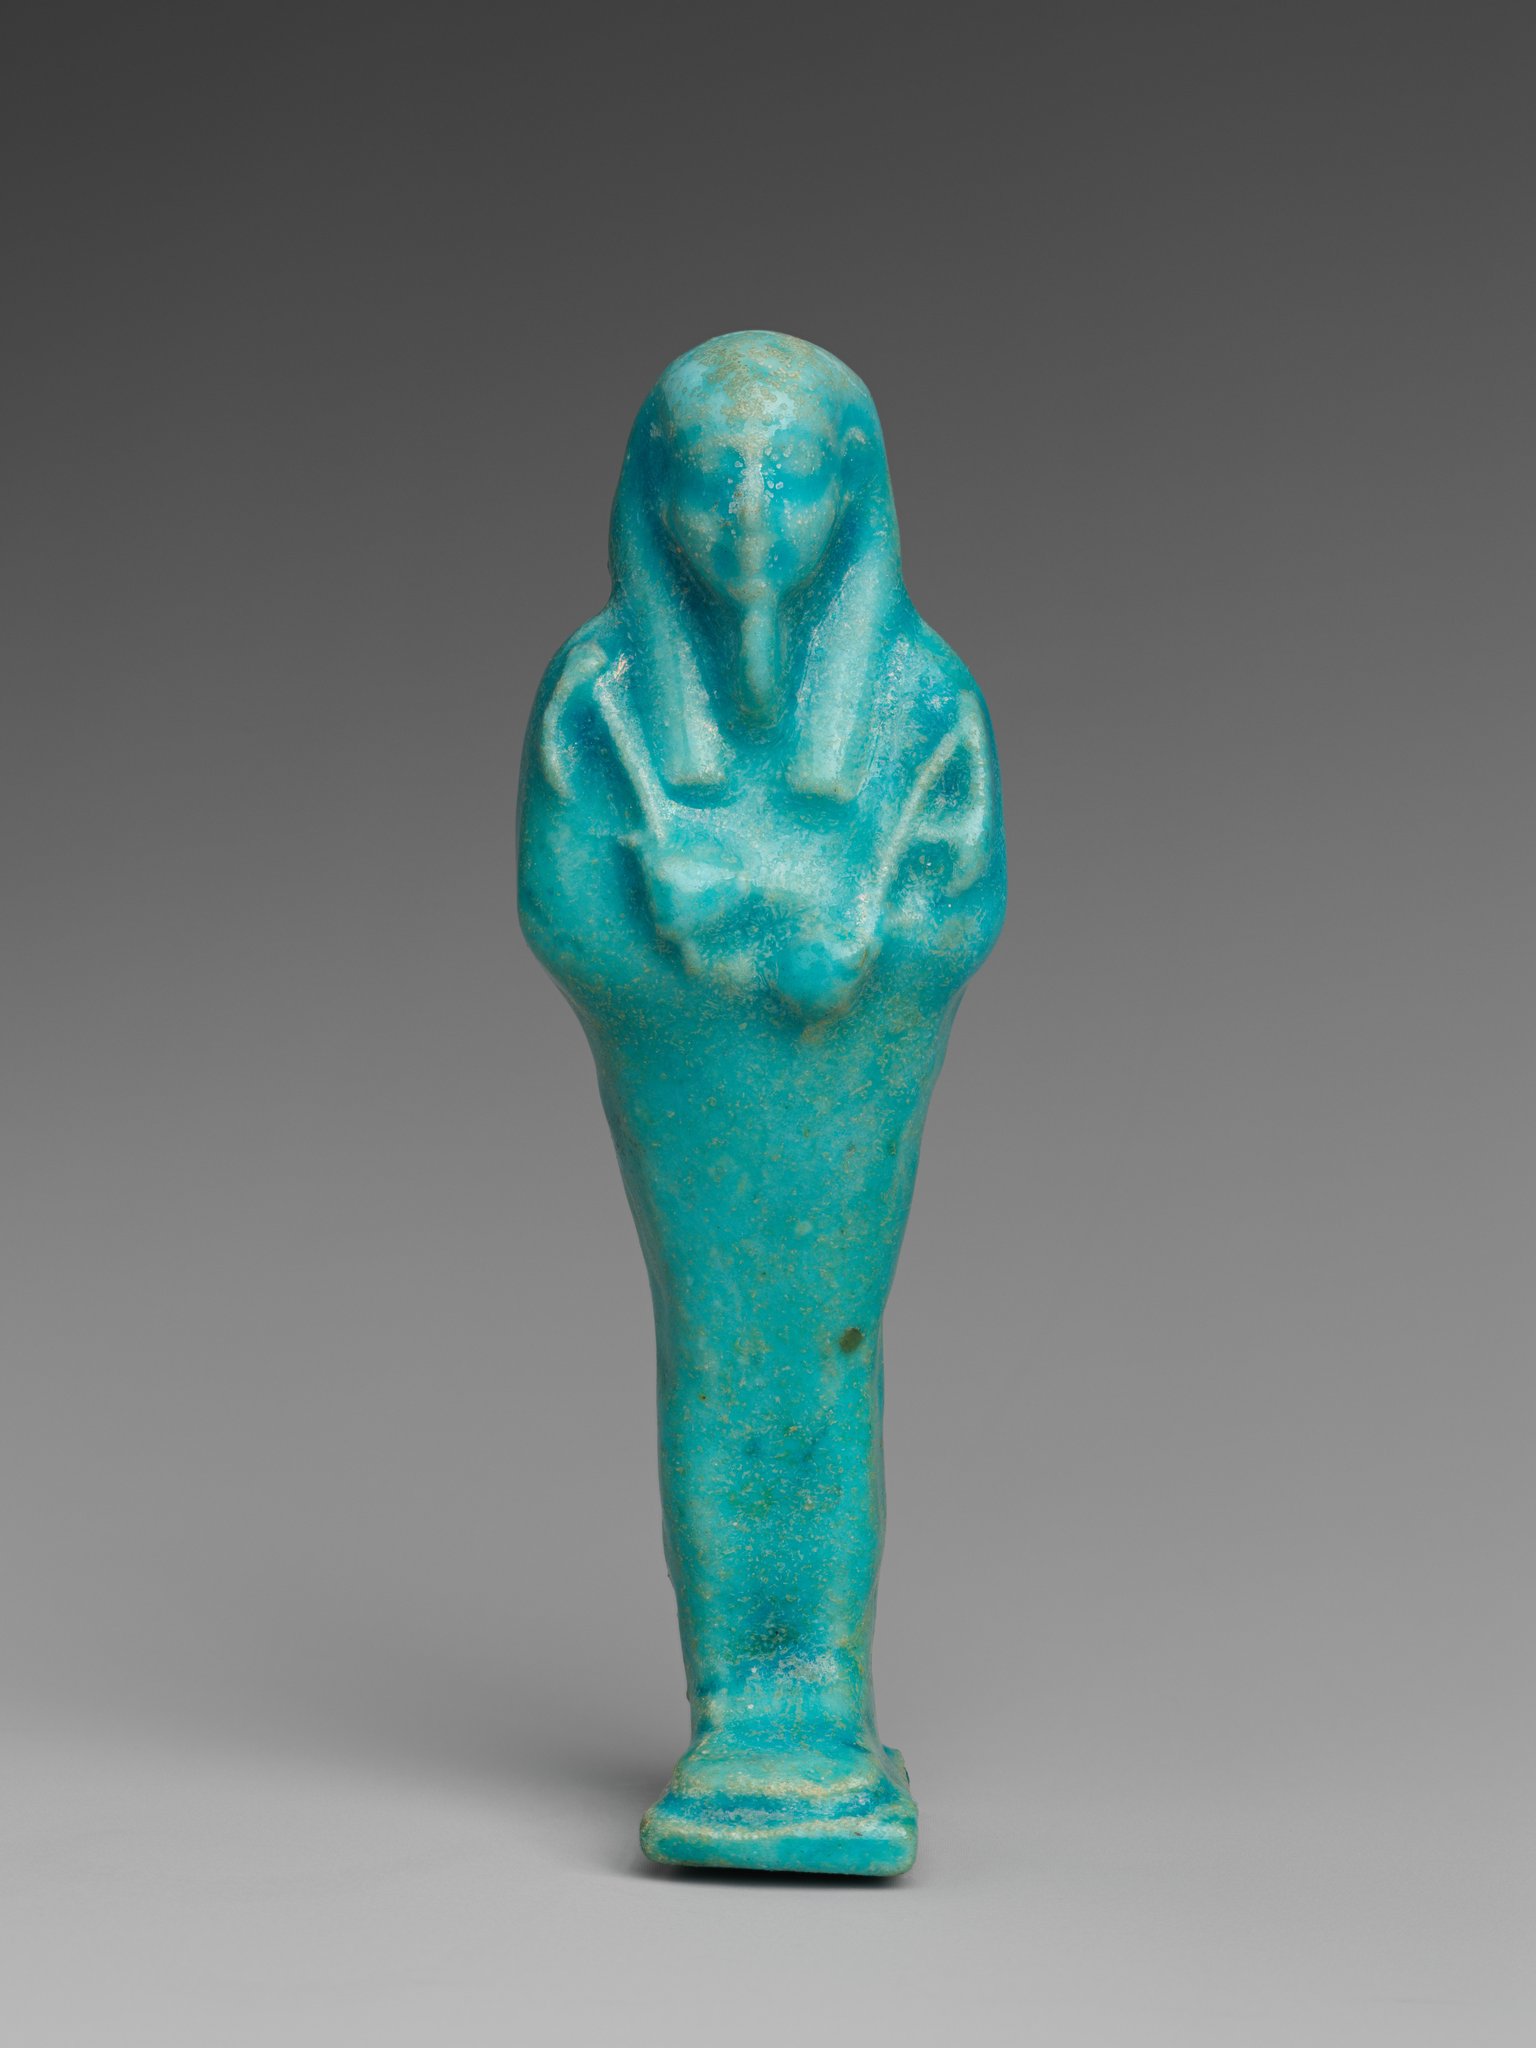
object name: shabti, petosiris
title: Shabti of Petosiris, son of Djedhor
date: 360-300 BCE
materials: faience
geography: egypt